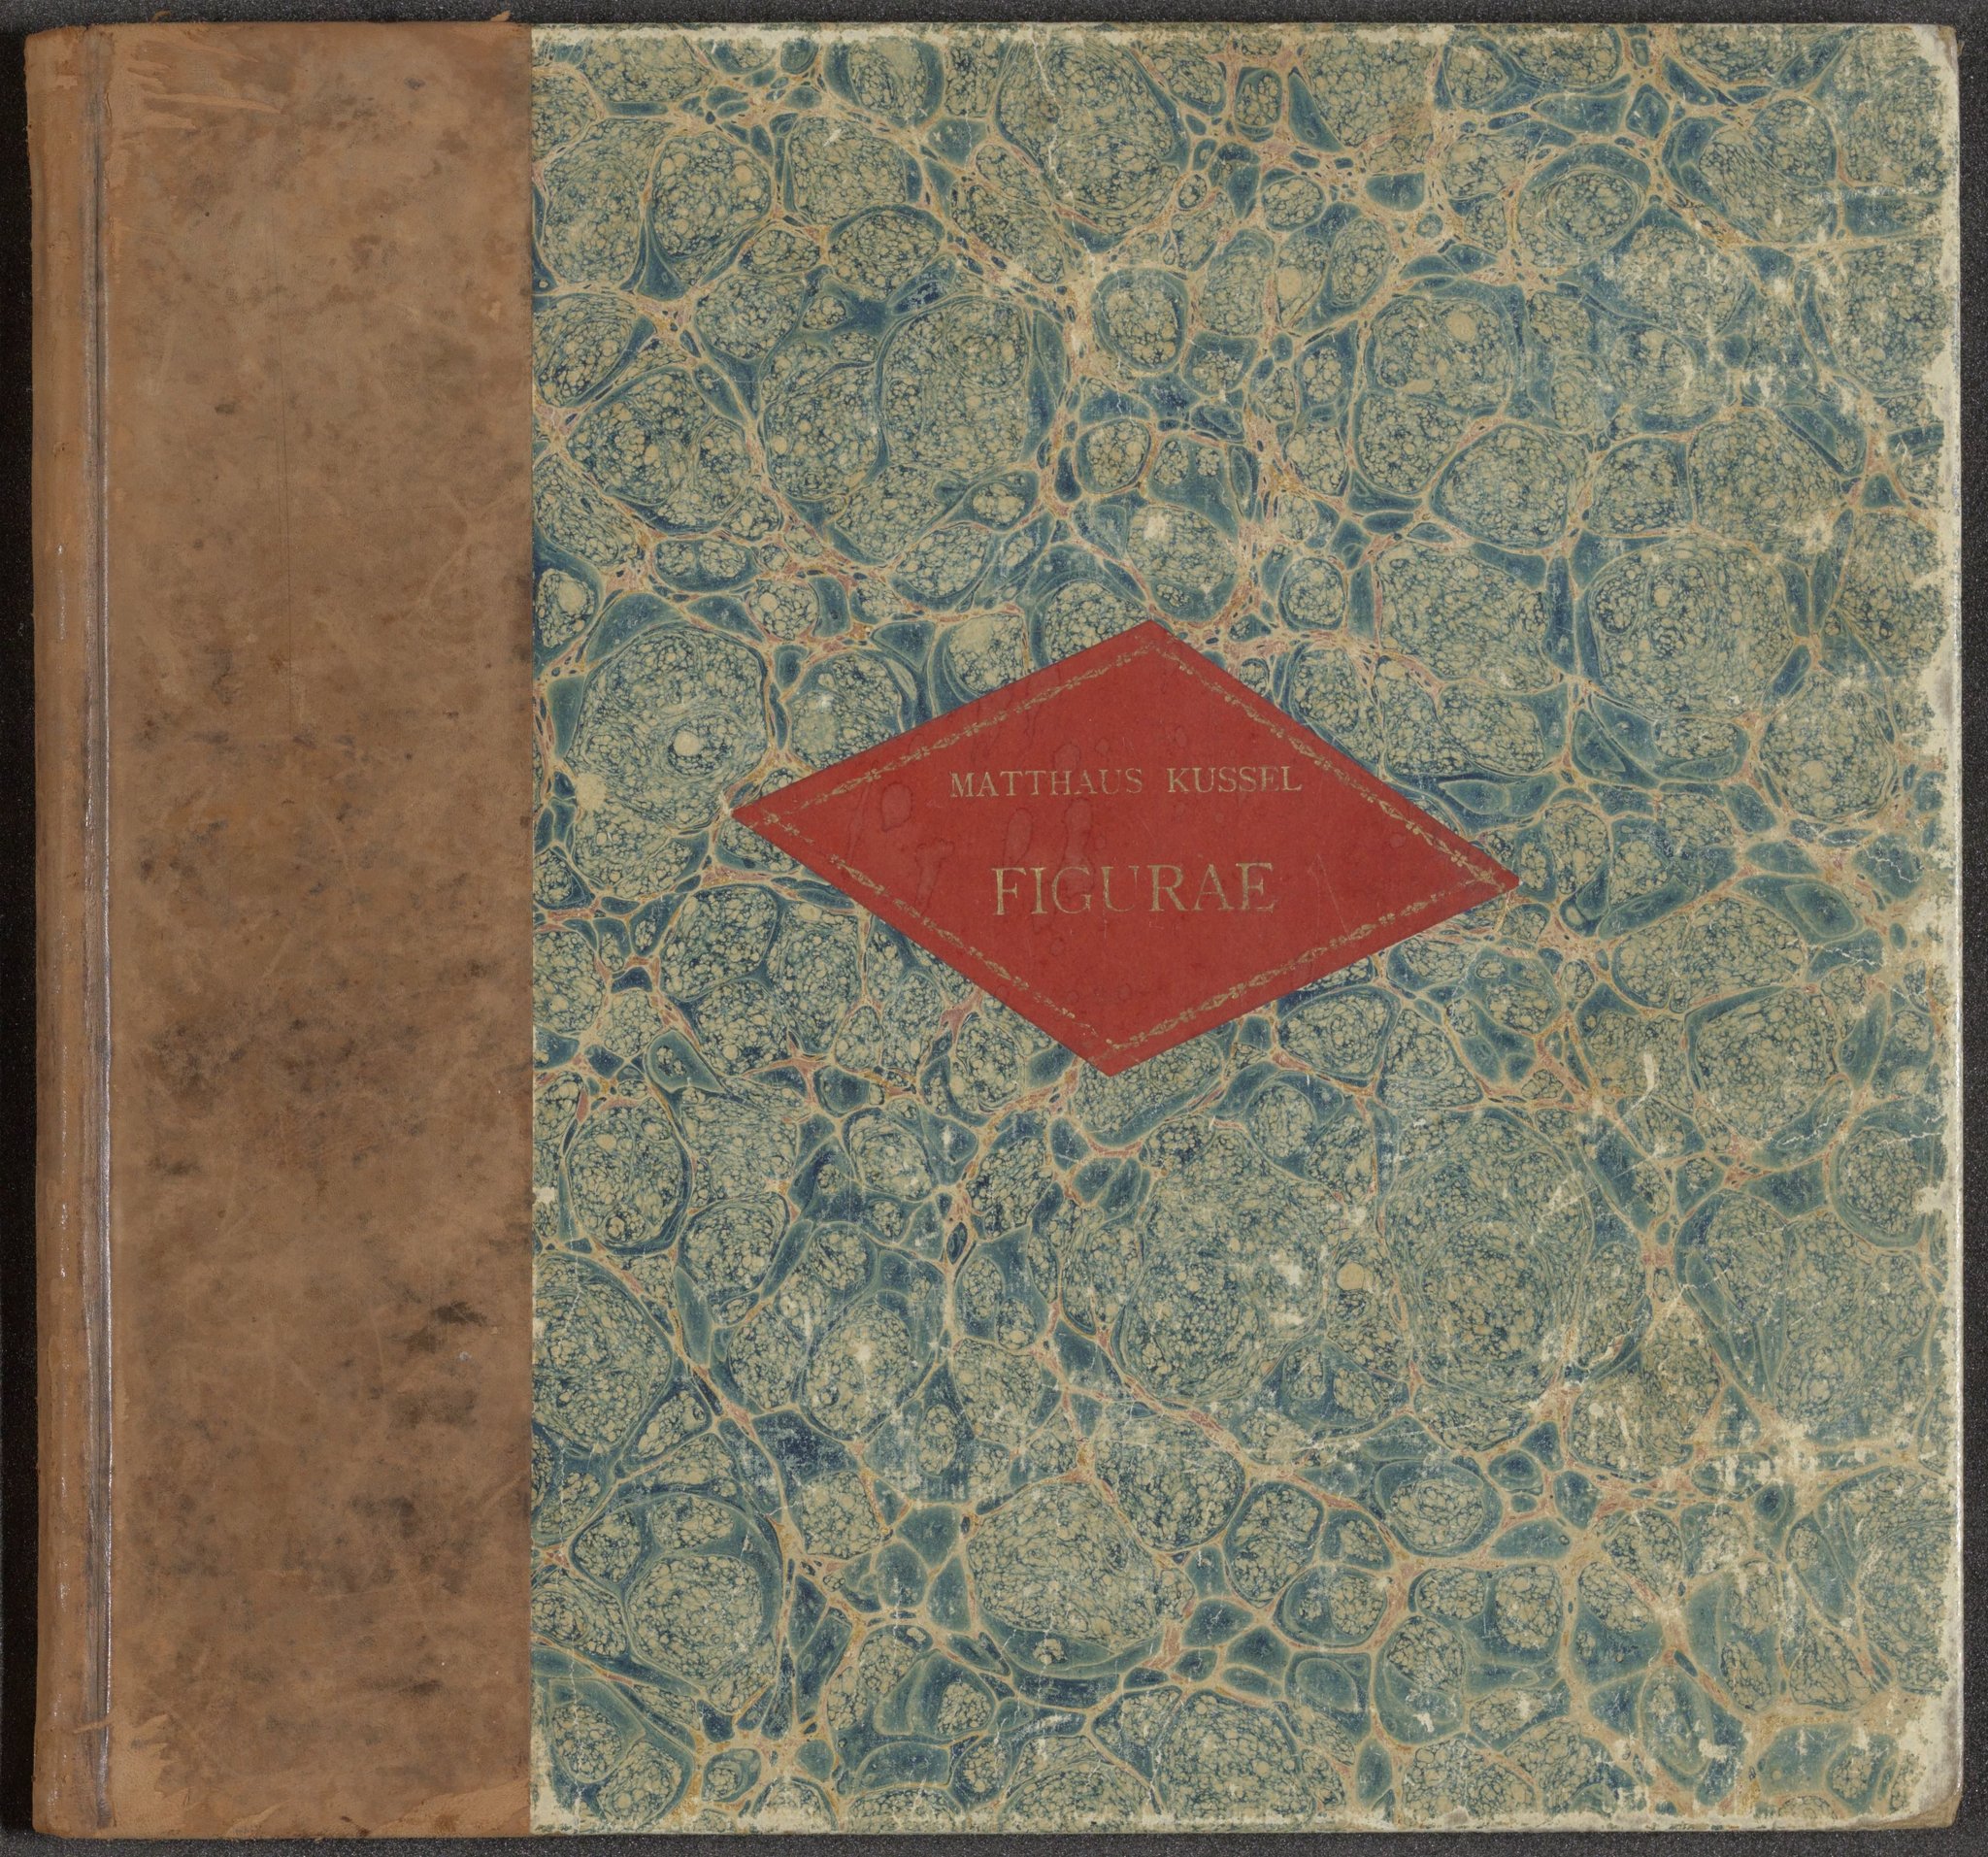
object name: prentrecueil, prentenalbum, prentalbum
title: Album met voorstellingen van de schone kunsten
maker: mathäus küsel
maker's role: print maker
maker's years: 1629-1681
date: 1639-1681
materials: leather, paper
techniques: bookbinding, etching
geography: augsburg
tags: the liberal arts, 'artes liberales', the graphic arts, painting (including book-illumination, miniature-painting)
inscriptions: collector's mark: Lugt 964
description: Album met elf prenten op elf albumbladen. Het album bevat tien voorstellingen gerelateerd aan de schone kunsten. De serie gaat vooraf door een prent met een dedicatie aan George Augustin von Stubenberg. Halfleren band met gemarmerde platten, voorin en achterin enkele schutbladen.